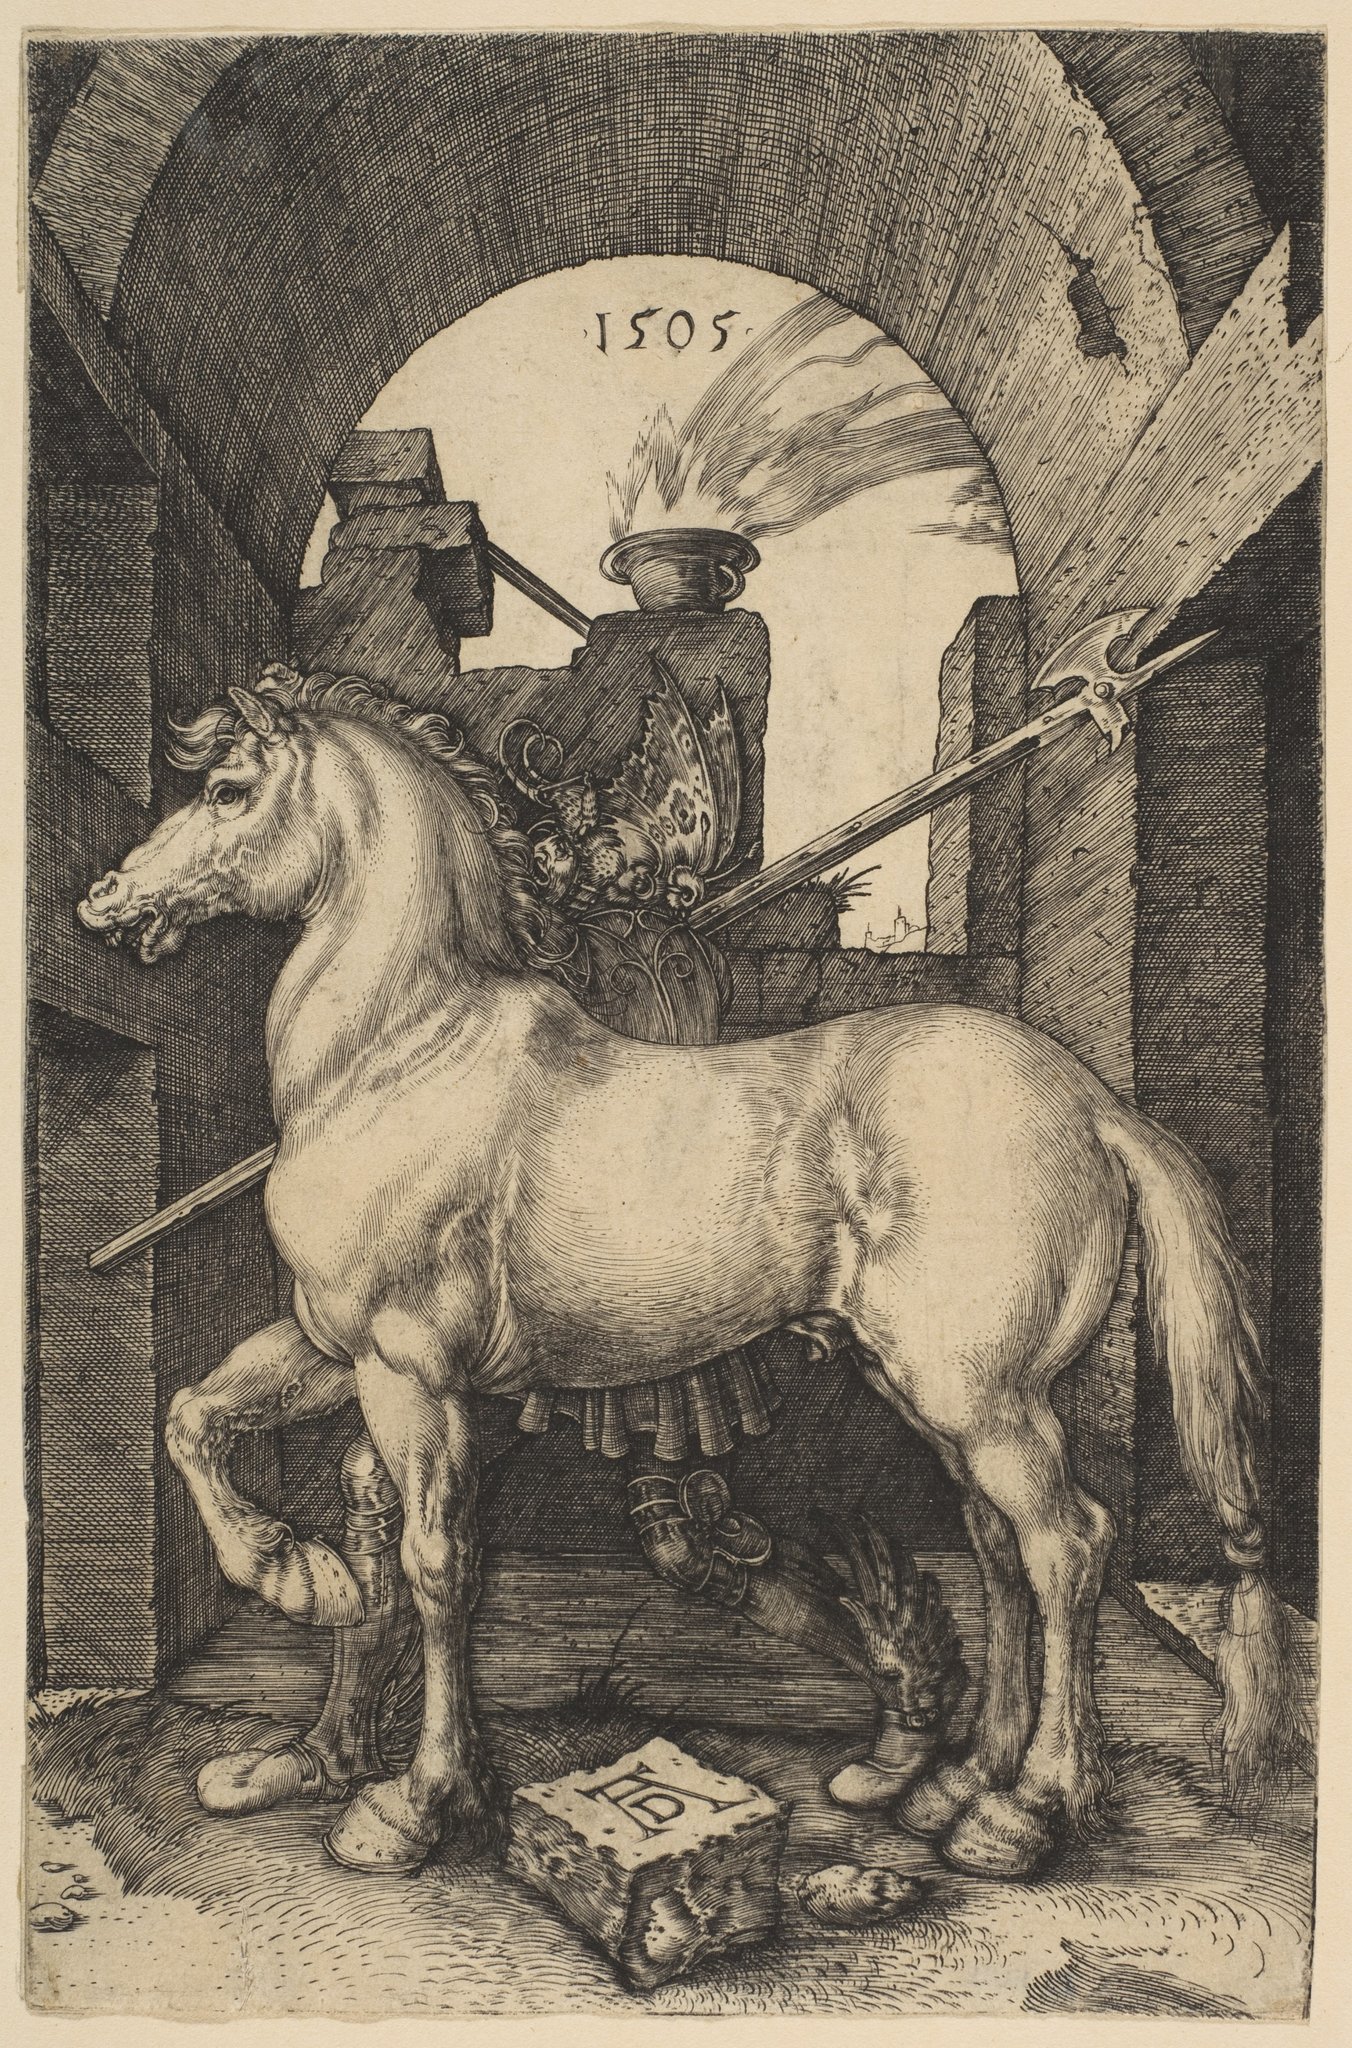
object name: print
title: The Little Horse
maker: albrecht dürer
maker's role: artist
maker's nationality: german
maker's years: 1471-1528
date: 1505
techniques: engraving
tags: horses